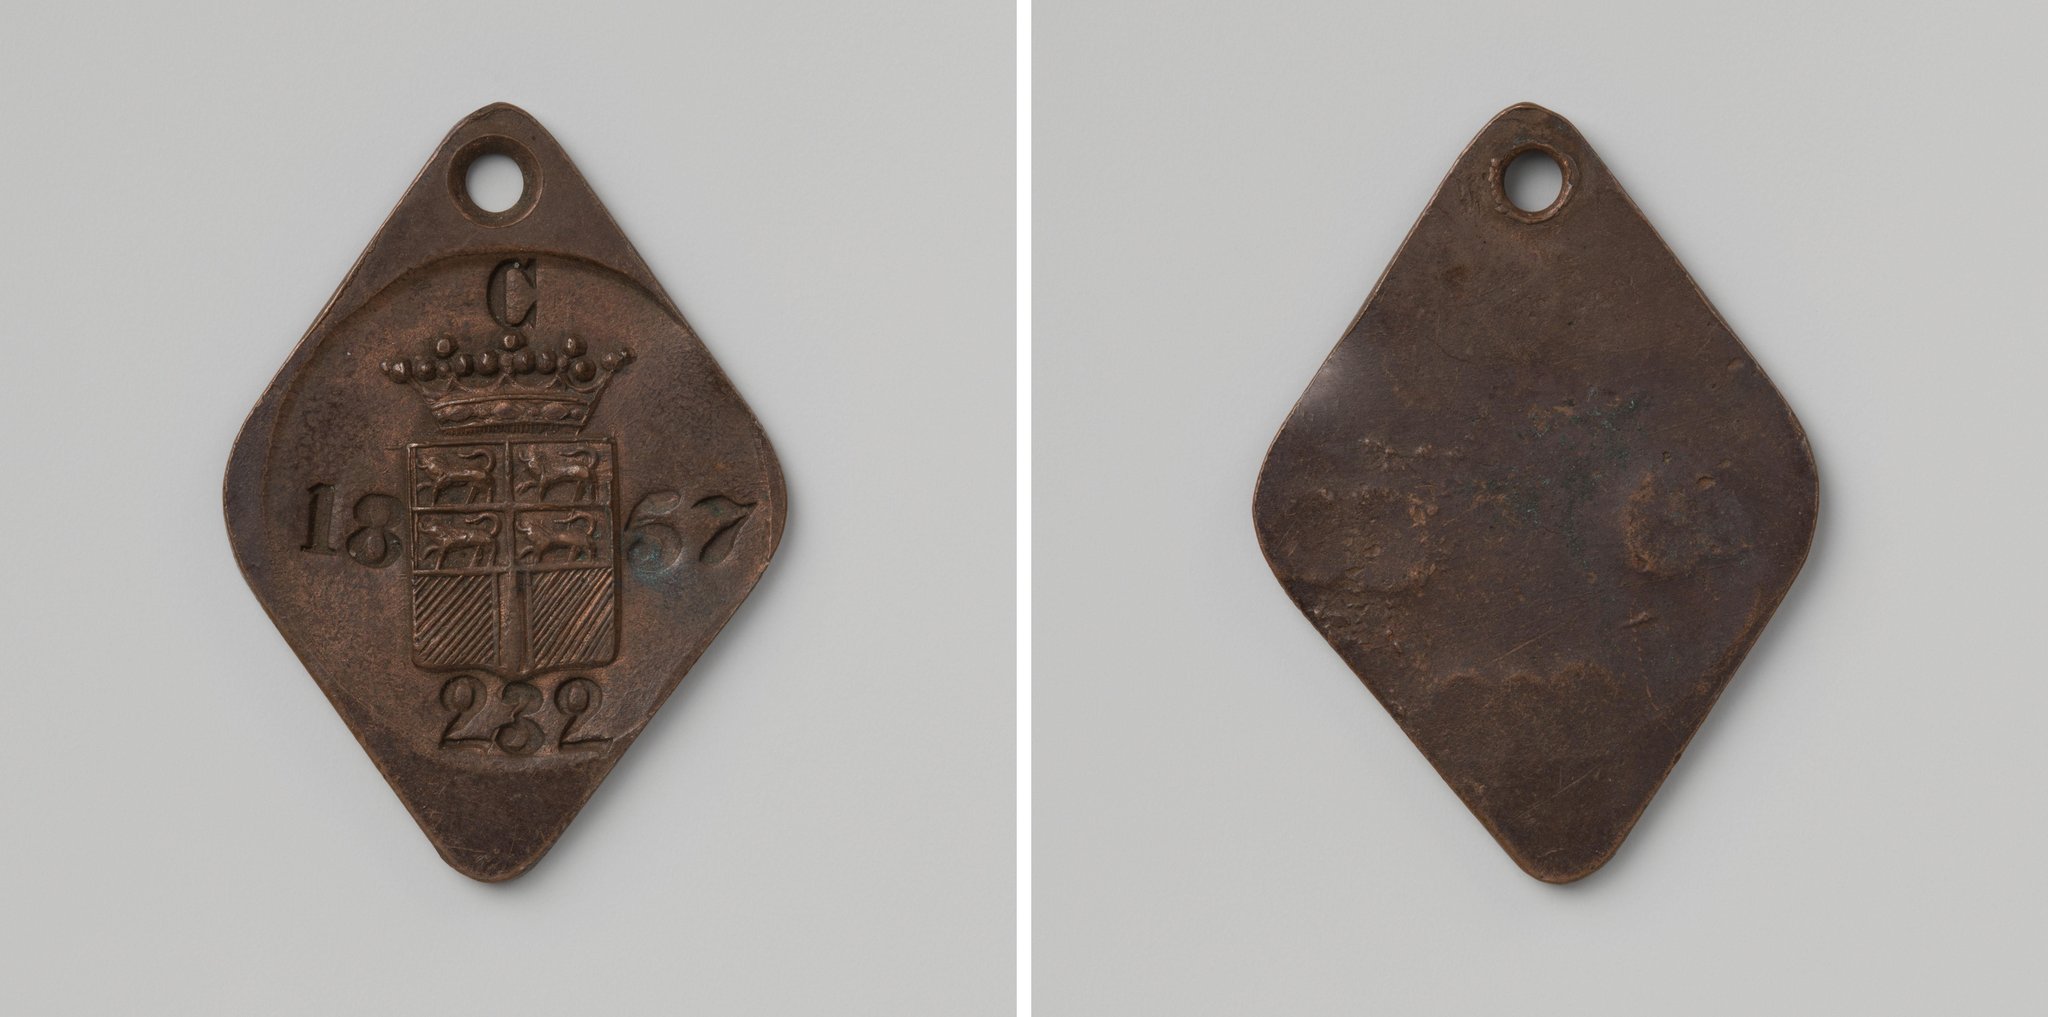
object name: tax token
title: Stad Rotterdam, loodje met letter C en no. 232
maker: Anonymous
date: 1857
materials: copper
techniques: striking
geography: rotterdam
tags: rotterdam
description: eenzijdig, ruitvormig loodje met afgeronde hoeken en gat erin. Voorzijde: gekroond wapenschild tussen jaartal boven cijfer 232; boven wapenschild: letter C. Keerzijde: blanco